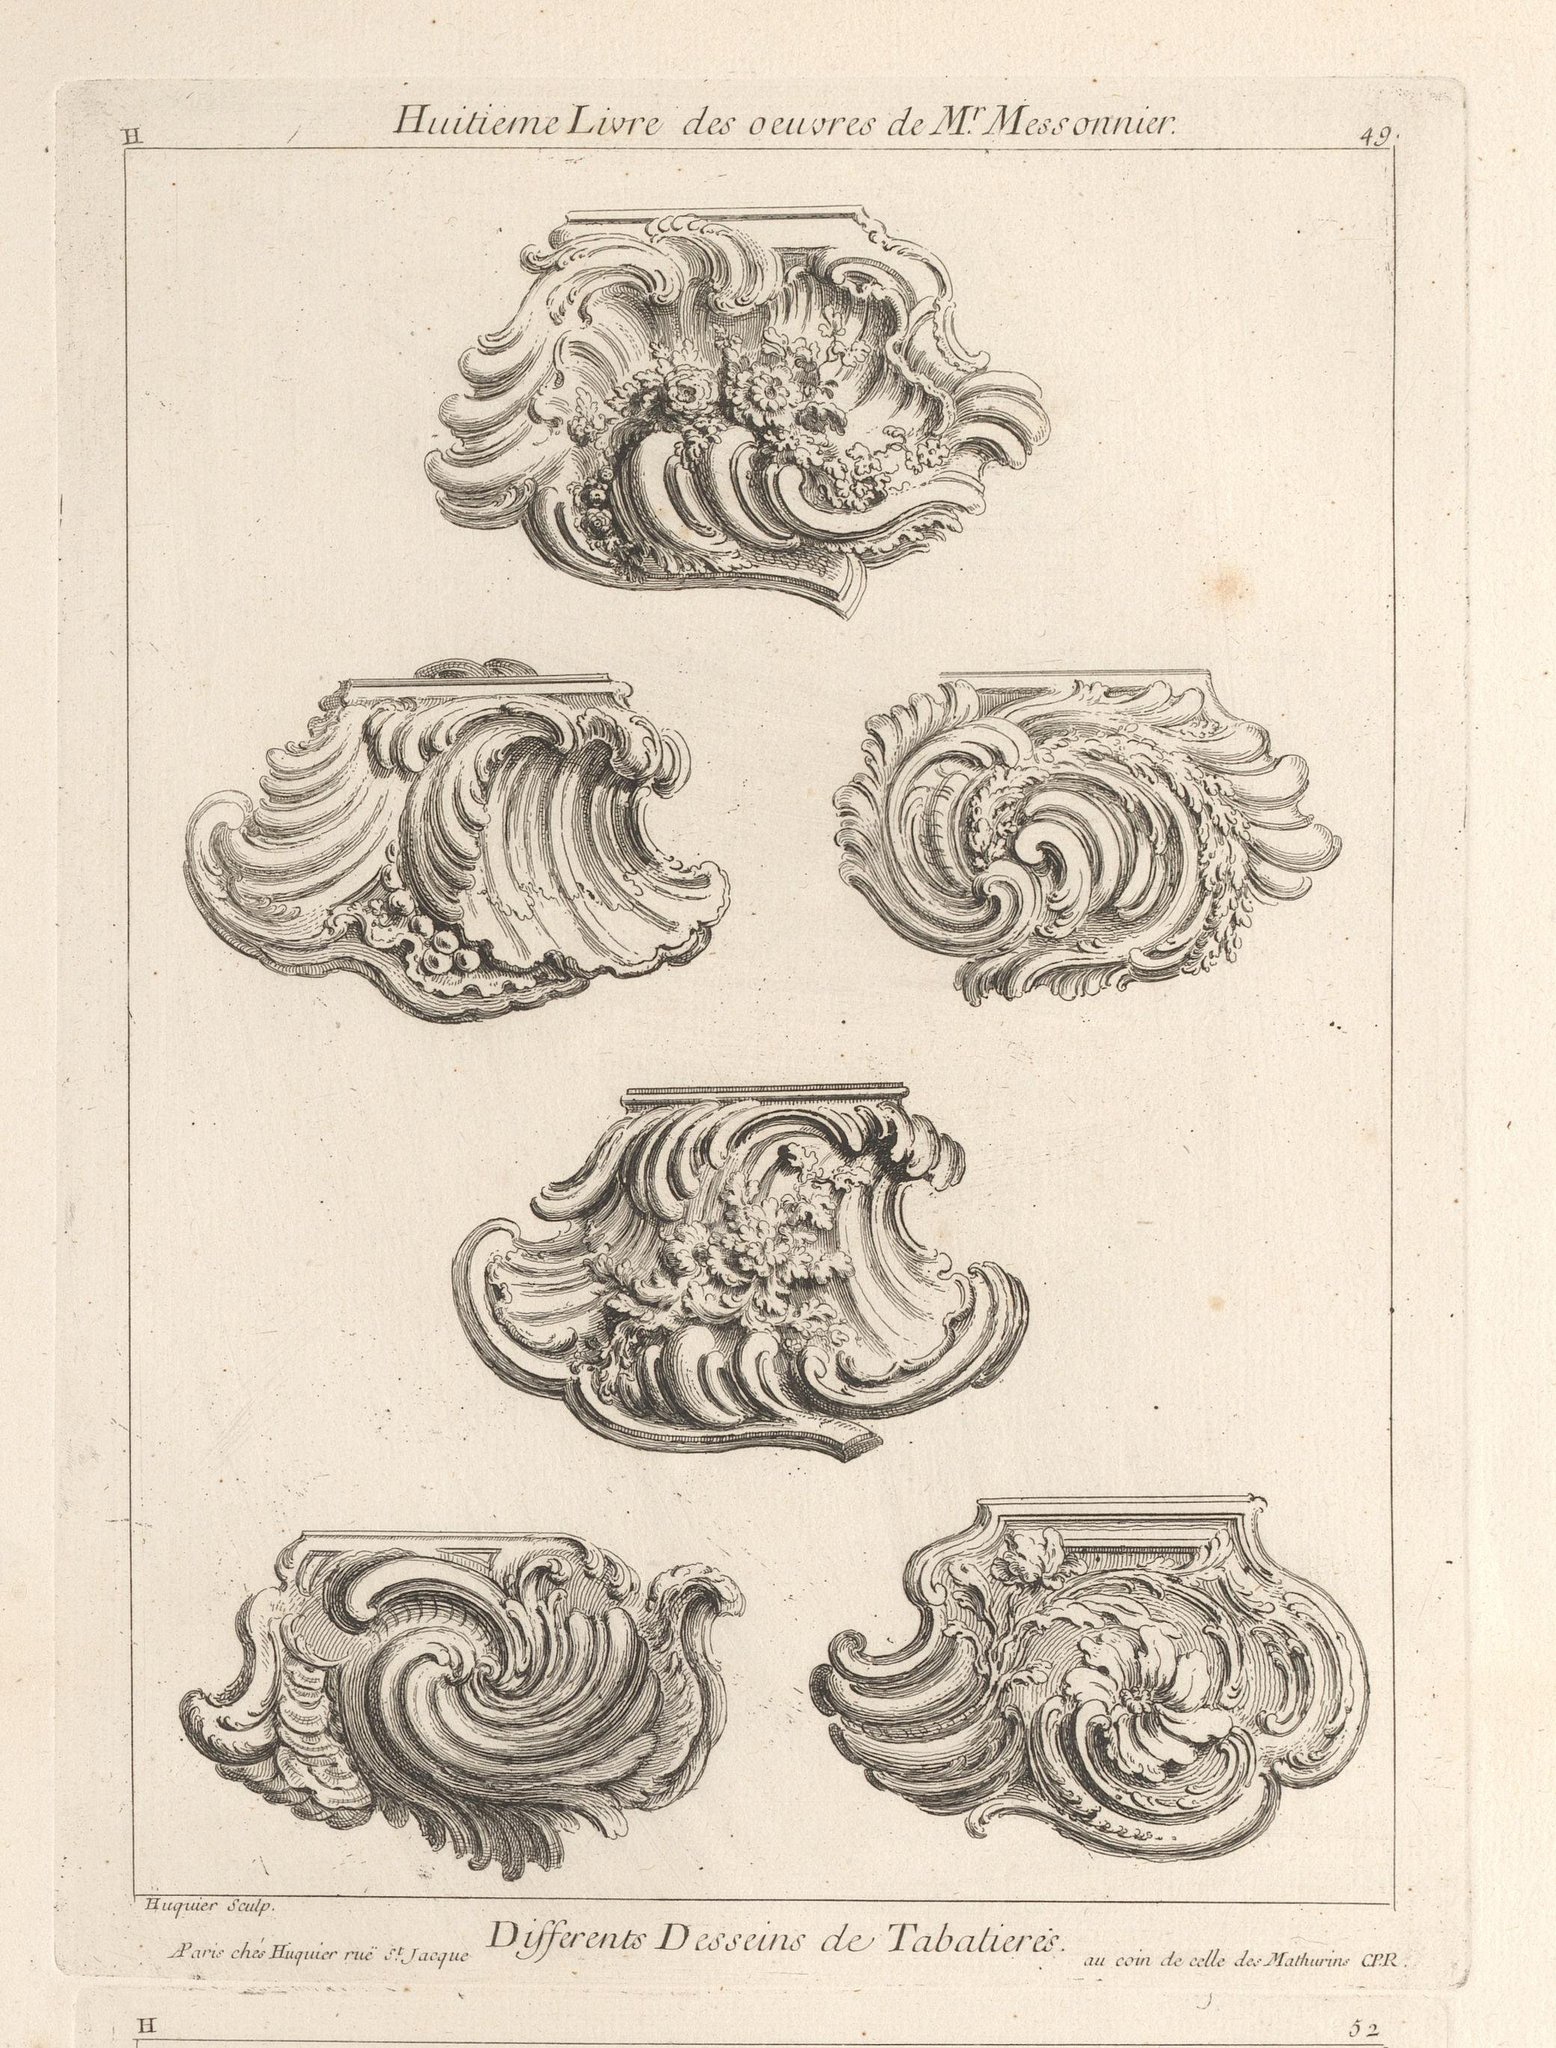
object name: ornament print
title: Differents desseins de tabatieres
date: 1738-1749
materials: paper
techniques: etching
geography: paris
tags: snuff-box, work of applied art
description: Deze prent maakt deel uit van de serie "Huitième livre des oeuvres de mr. Messonnier", een van de delen van de monumentale serie "Oeuvre de Juste Aurele Meissonnier".